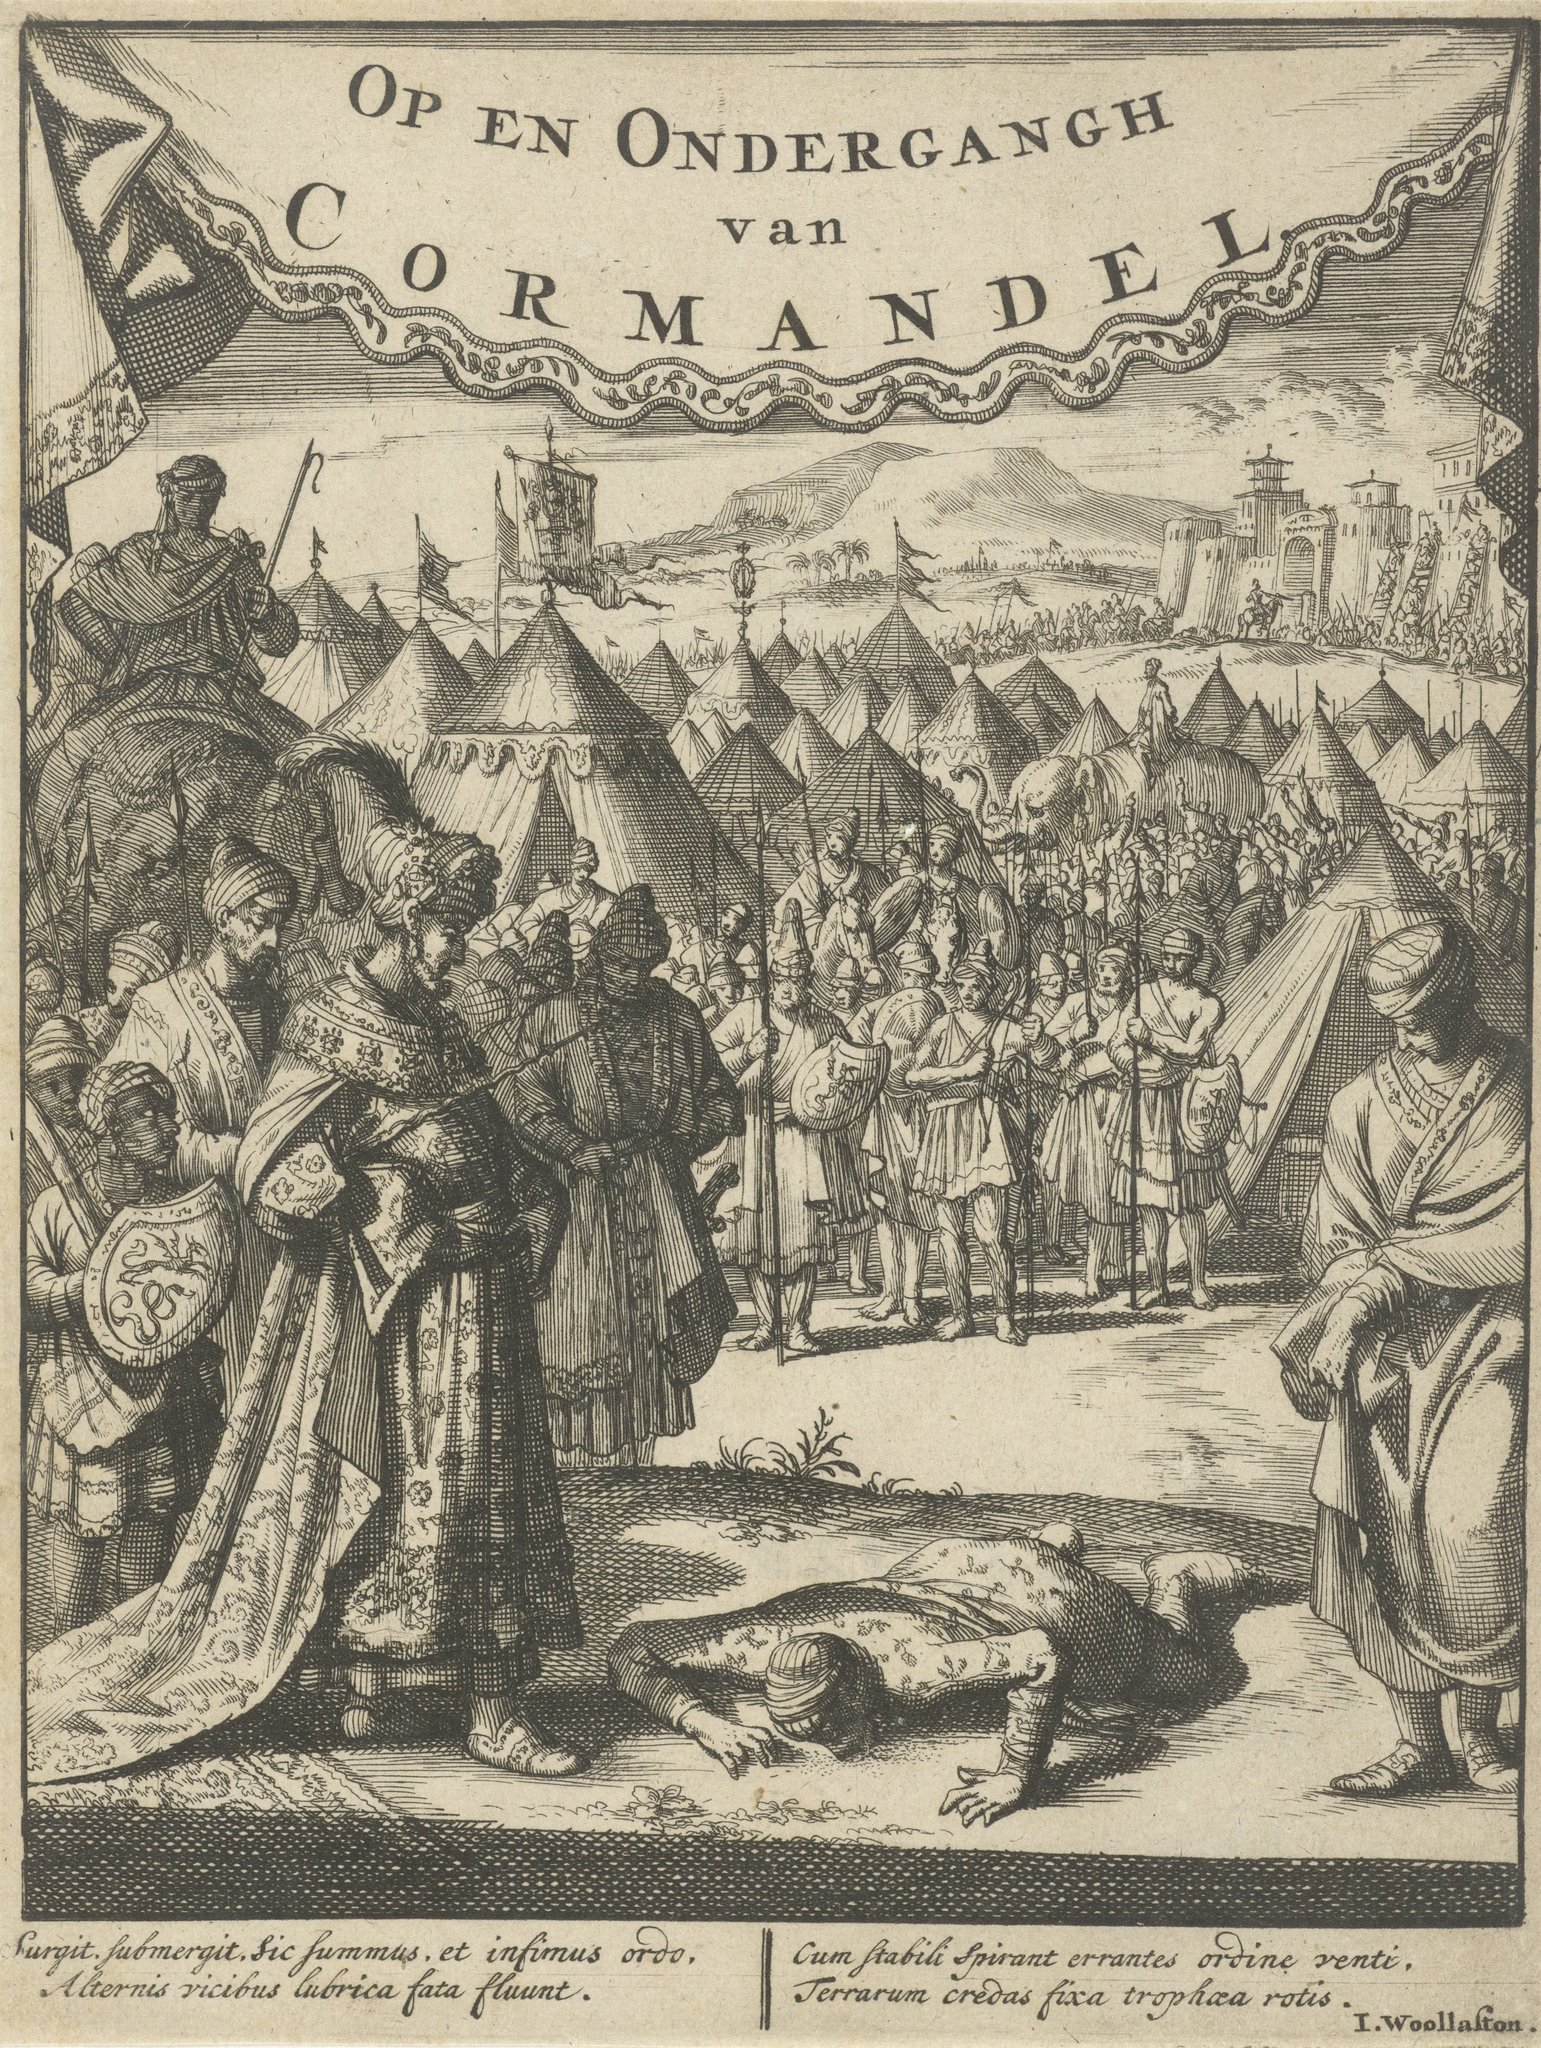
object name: titelblad, titelpagina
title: Titelpagina voor: D. Havart, Op- en ondergang van Cormandel, 1693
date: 1693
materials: paper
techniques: etching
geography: amsterdam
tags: (military) camp with tents, the defeated (after the battle), surrender ~ war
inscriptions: collector's mark: Lugt 2228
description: Titelpagina voor: Havart, Daniël. Op- en ondergang van Cormandel, 2 delen. Amsterdam: Jan Claesz ten Hoorn, 1693.